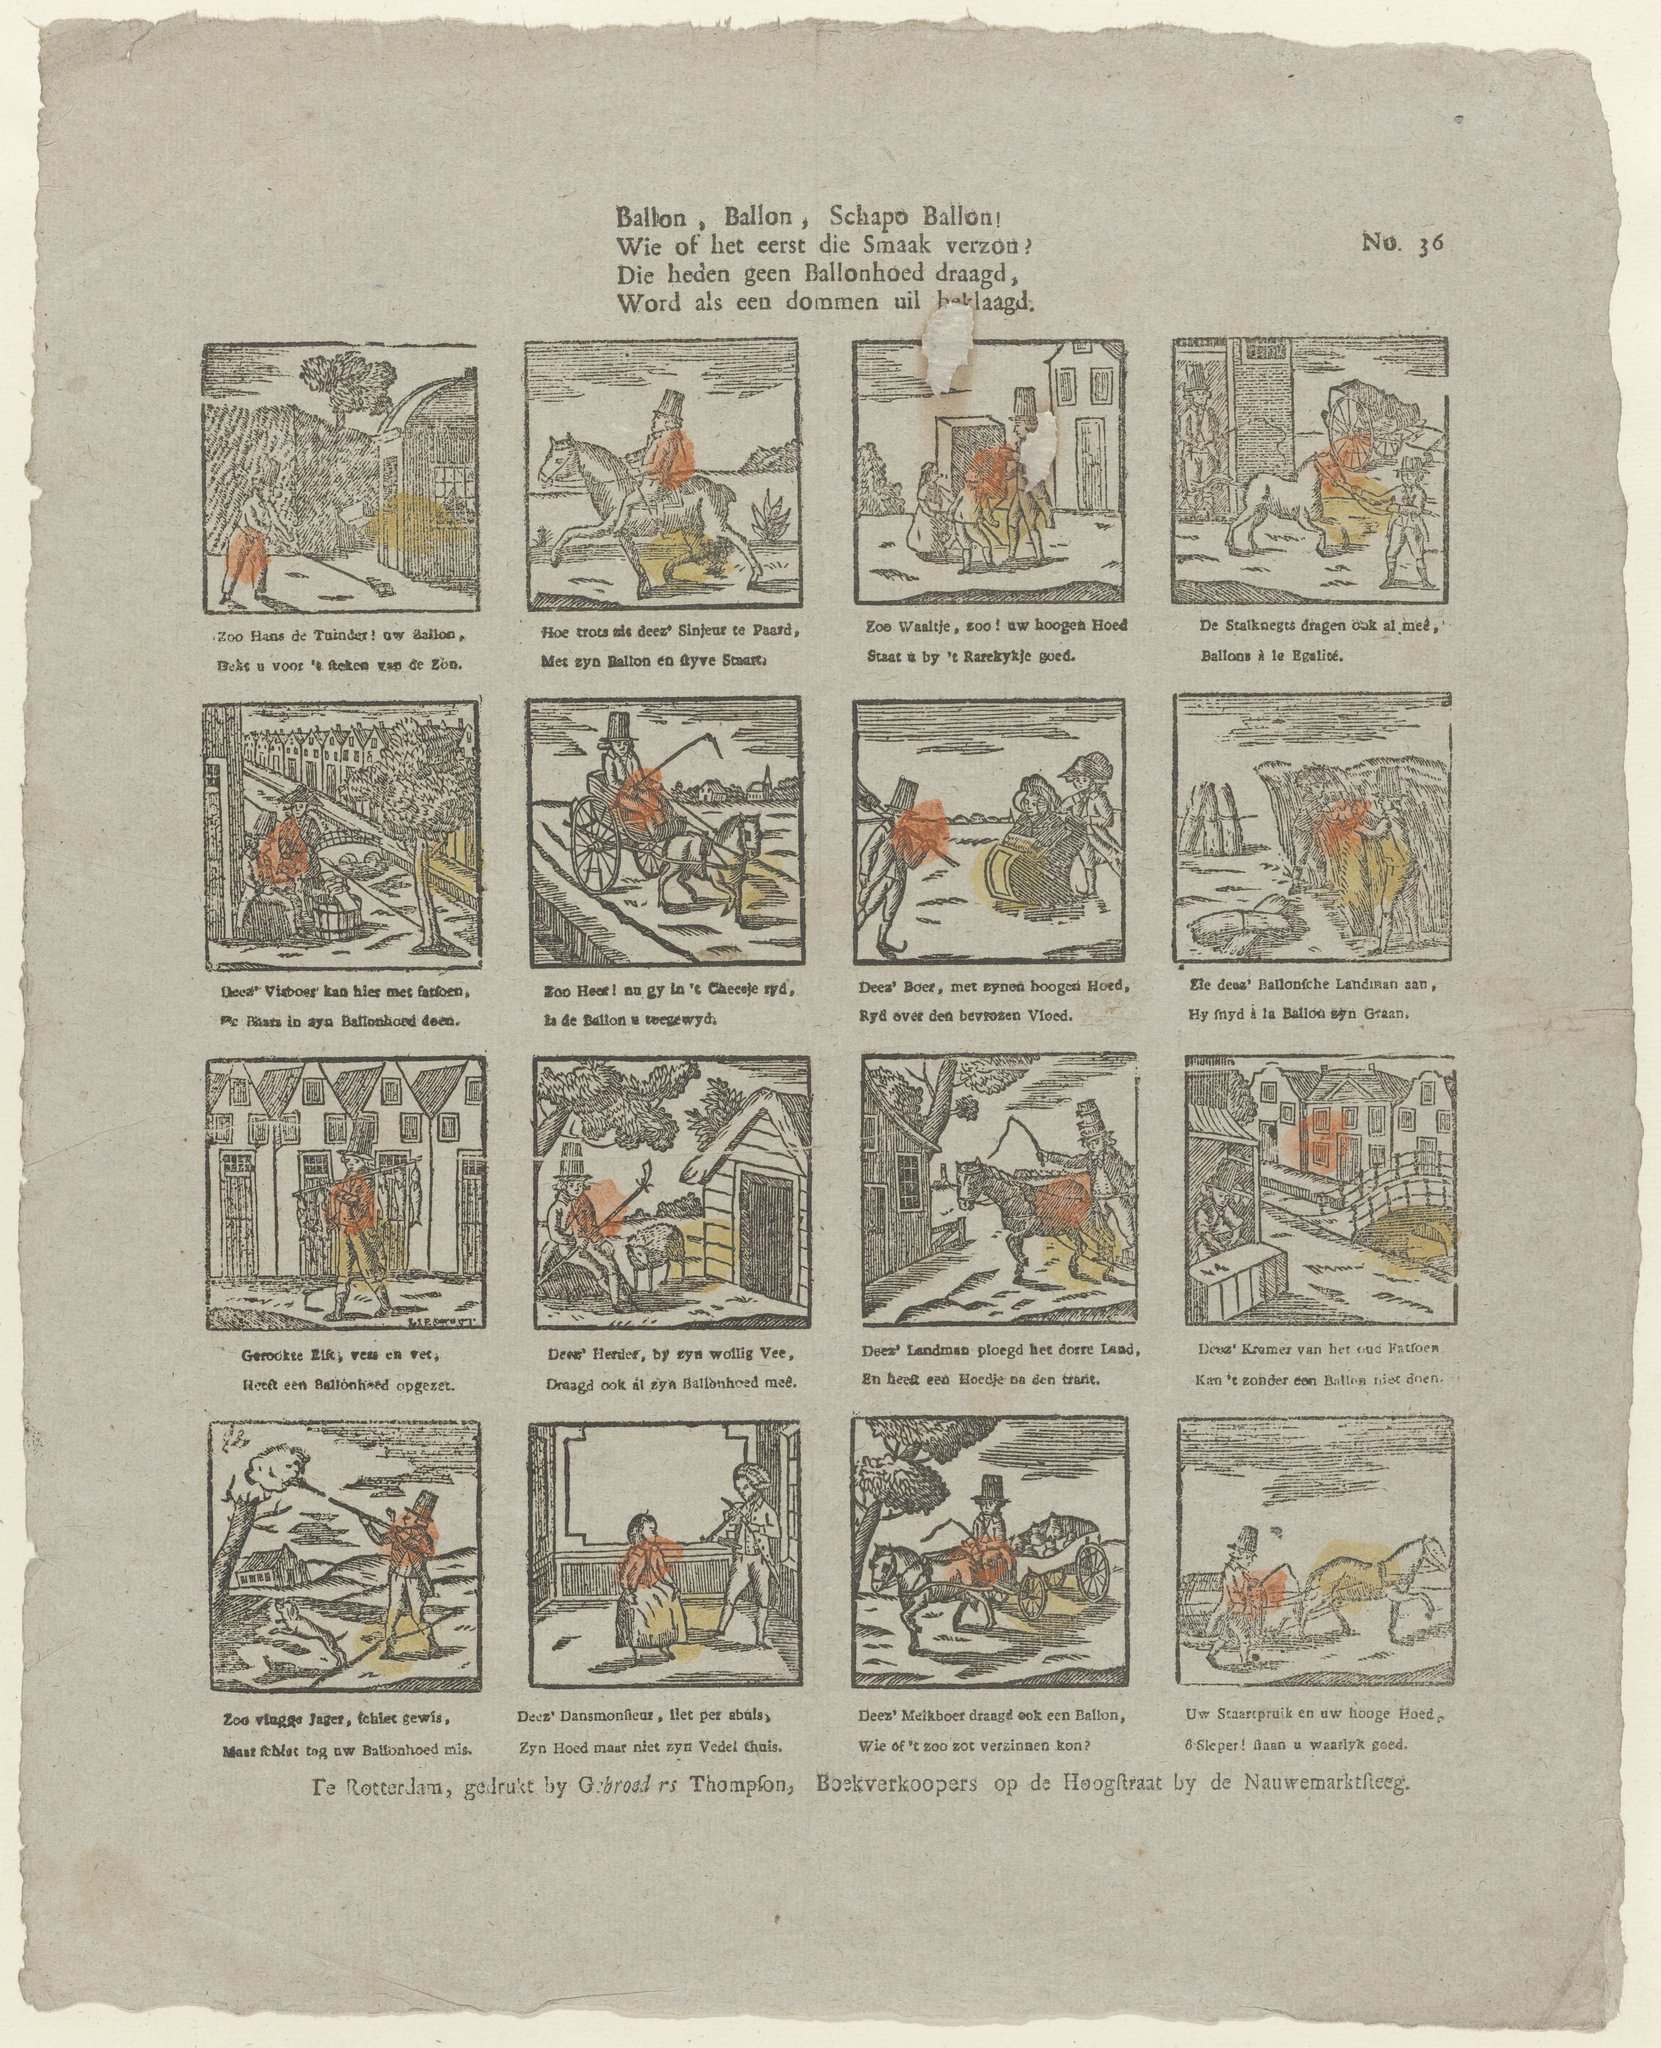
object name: popular print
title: Ballon, ballon, schapo ballon! / Wie of het eerst die smaak verzon? / Die heden geen ballonhoed draagd, / Word als een dommen uit beklaagd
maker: johannes egbertus van lieshout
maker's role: print maker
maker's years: 1770-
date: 1825-1829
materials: paper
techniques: colour, letterpress printing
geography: netherlands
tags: fashion, clothing, head-gear: top hat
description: Spotprent op de mode met 16 voorstellingen over het dragen van een hoge hoed bij verschillende beroepen en activiteiten. Onder elke afbeelding een tweeregelig vers. Genummerd rechtsboven: No. 36.